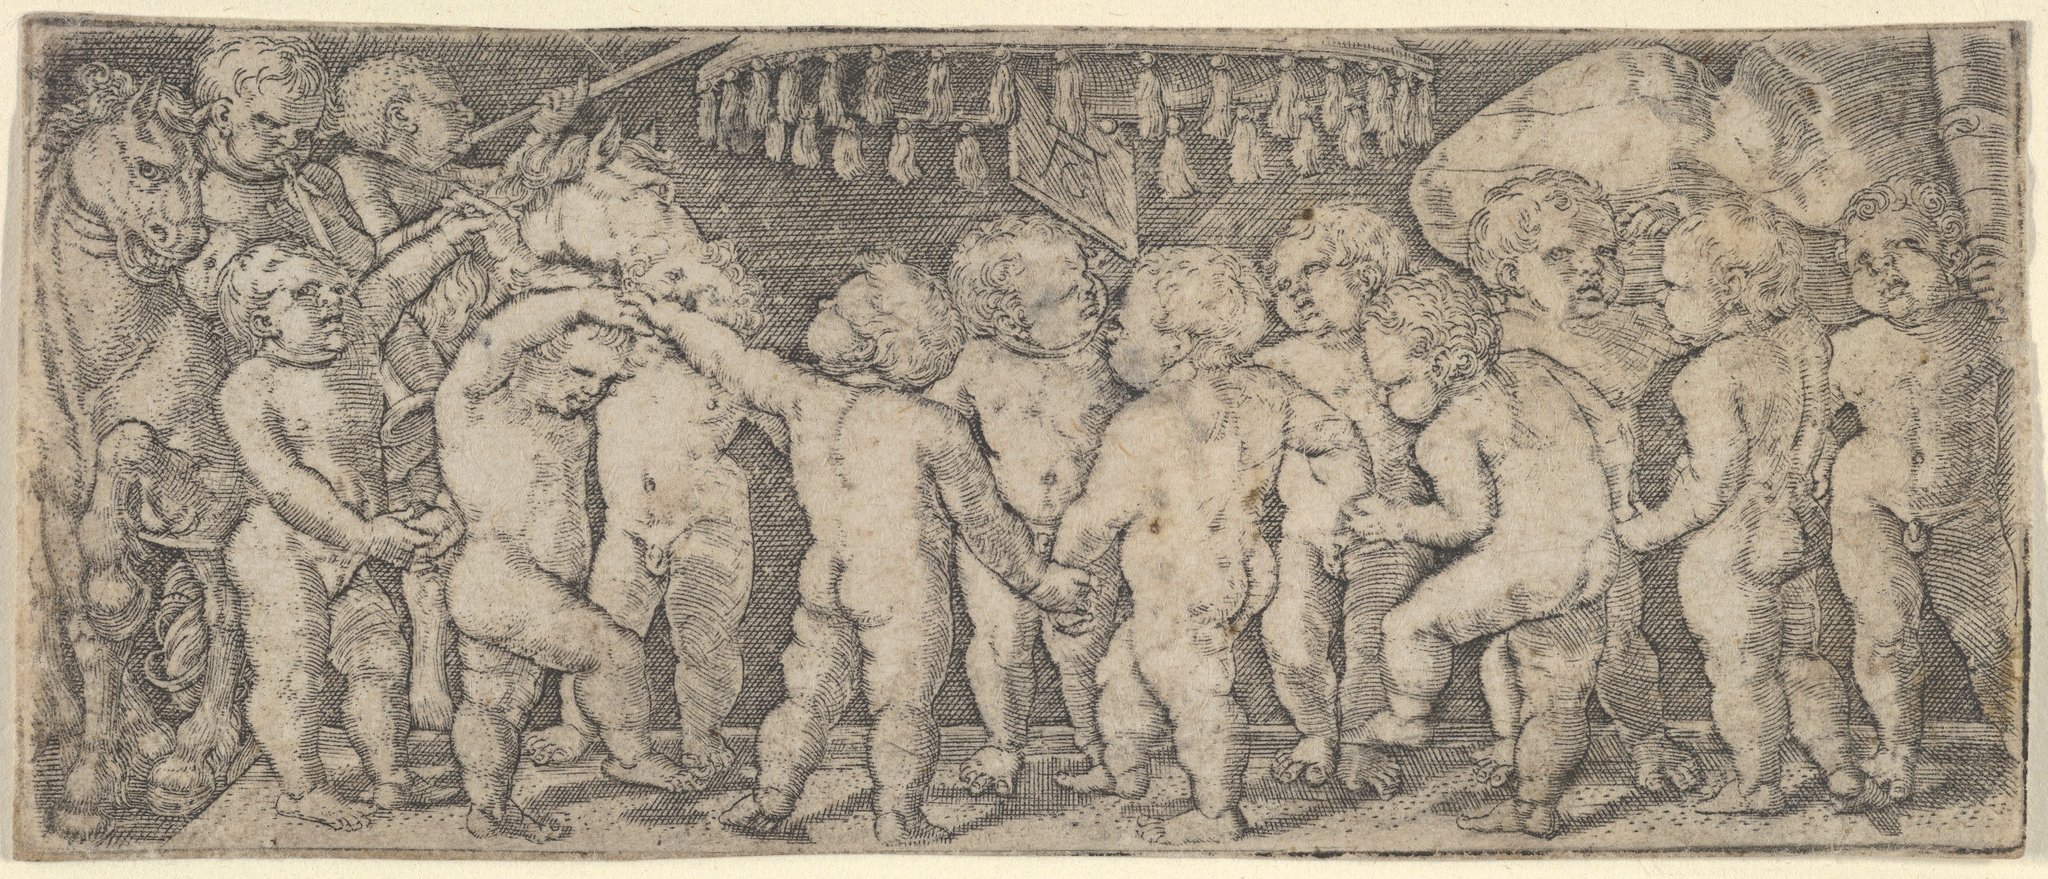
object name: print ornament architecture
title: Nude Children Dancing Under a Canopy, with Two Horses on the Left and a Banner on the Right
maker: heinrich aldegrever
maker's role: artist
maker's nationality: german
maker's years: 1502-1561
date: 1532-1533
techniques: engraving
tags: ornament,children,horses